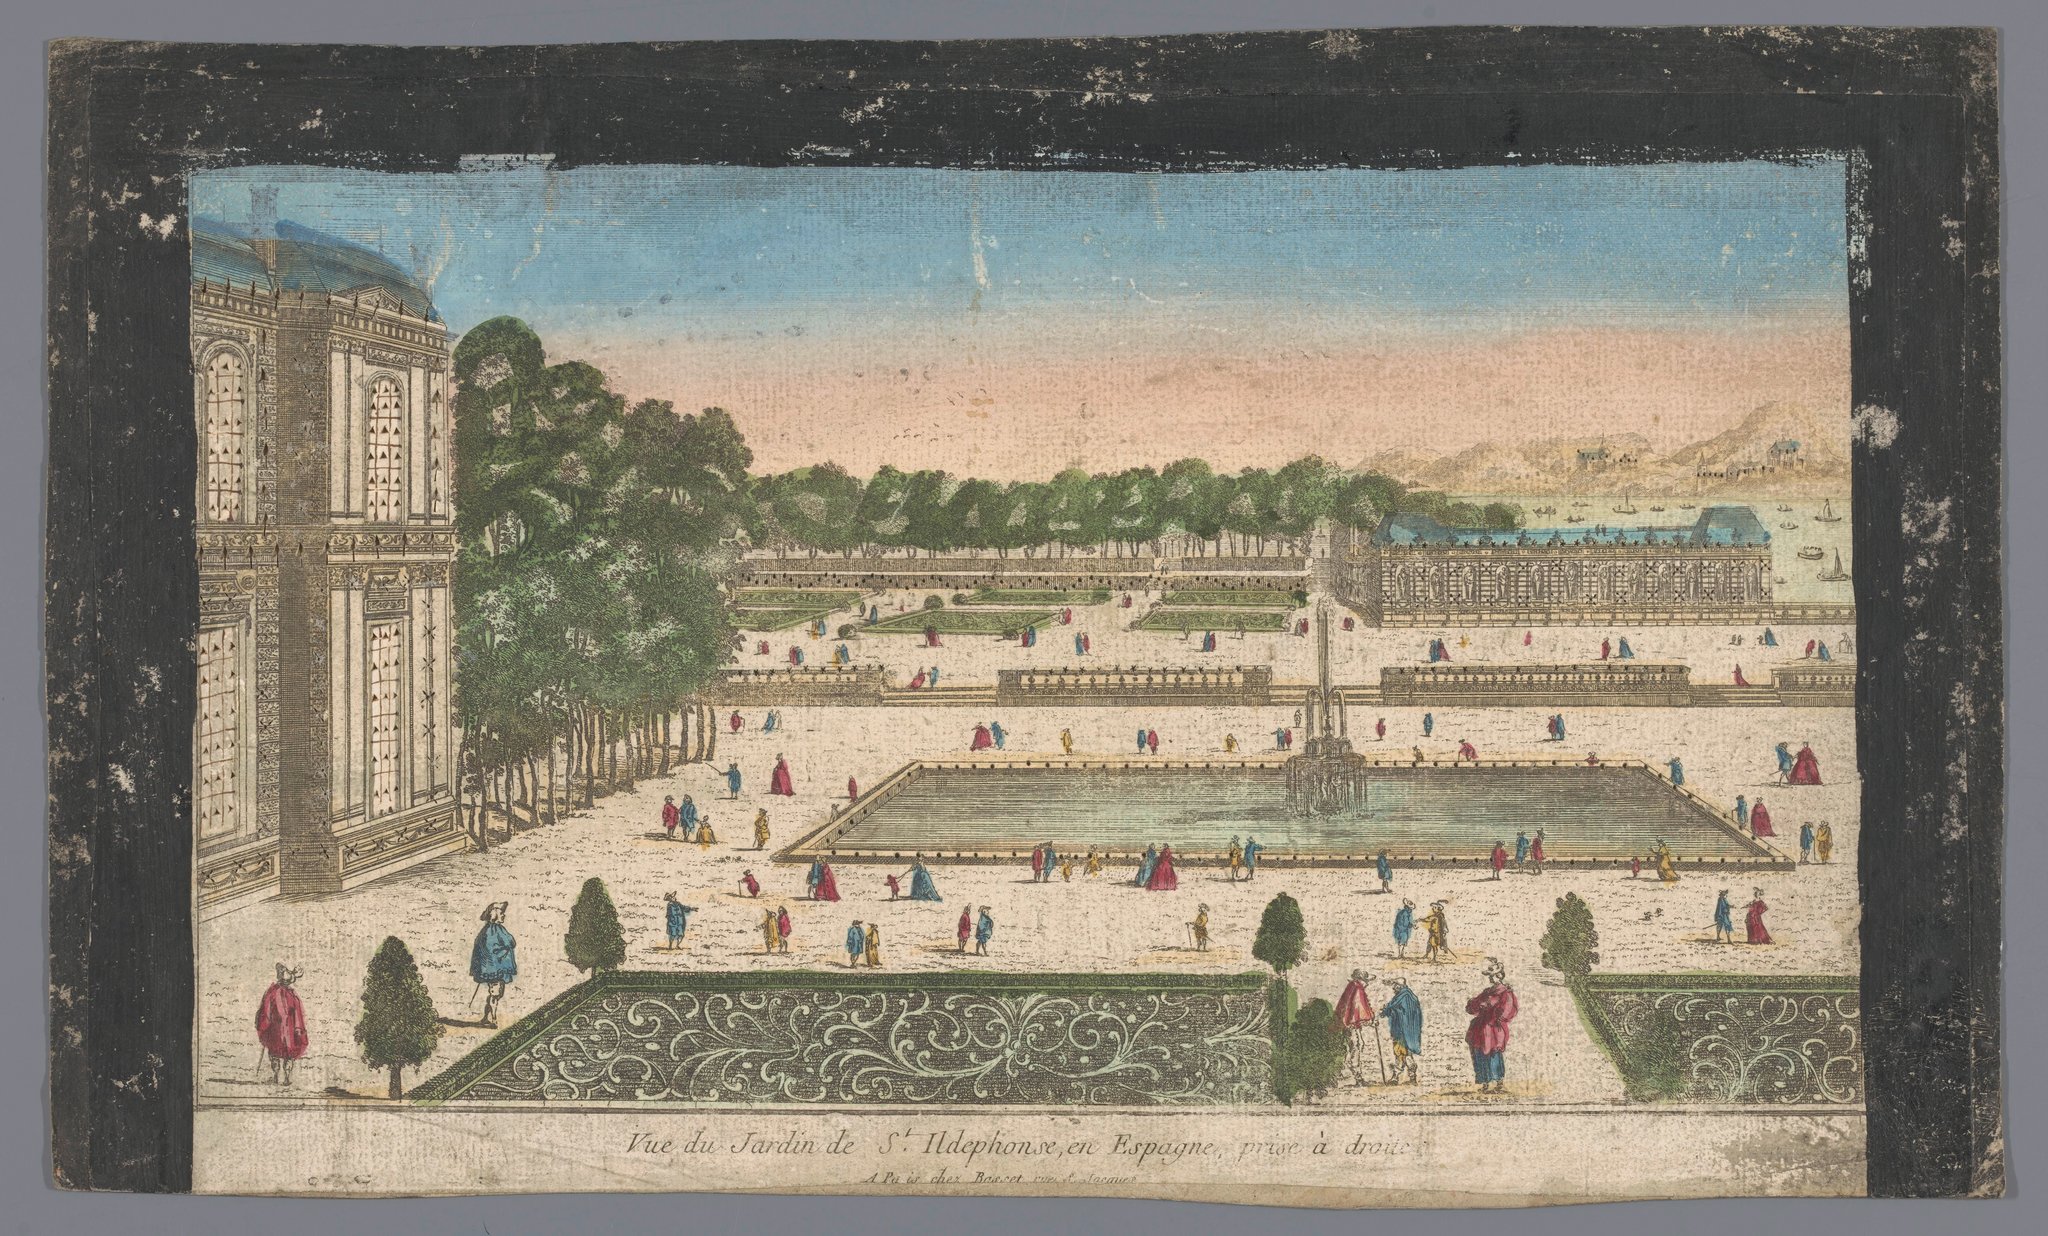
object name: opticaprent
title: Gezicht op de tuin van het Palacio Real de La Granja de San Ildefonso in de omgeving van de stad Madrid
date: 1700-1799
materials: cardboard, paint, paper, watercolor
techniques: brush, cutting, etching, perforating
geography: paris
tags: garden, garden fountain, ornamental plants